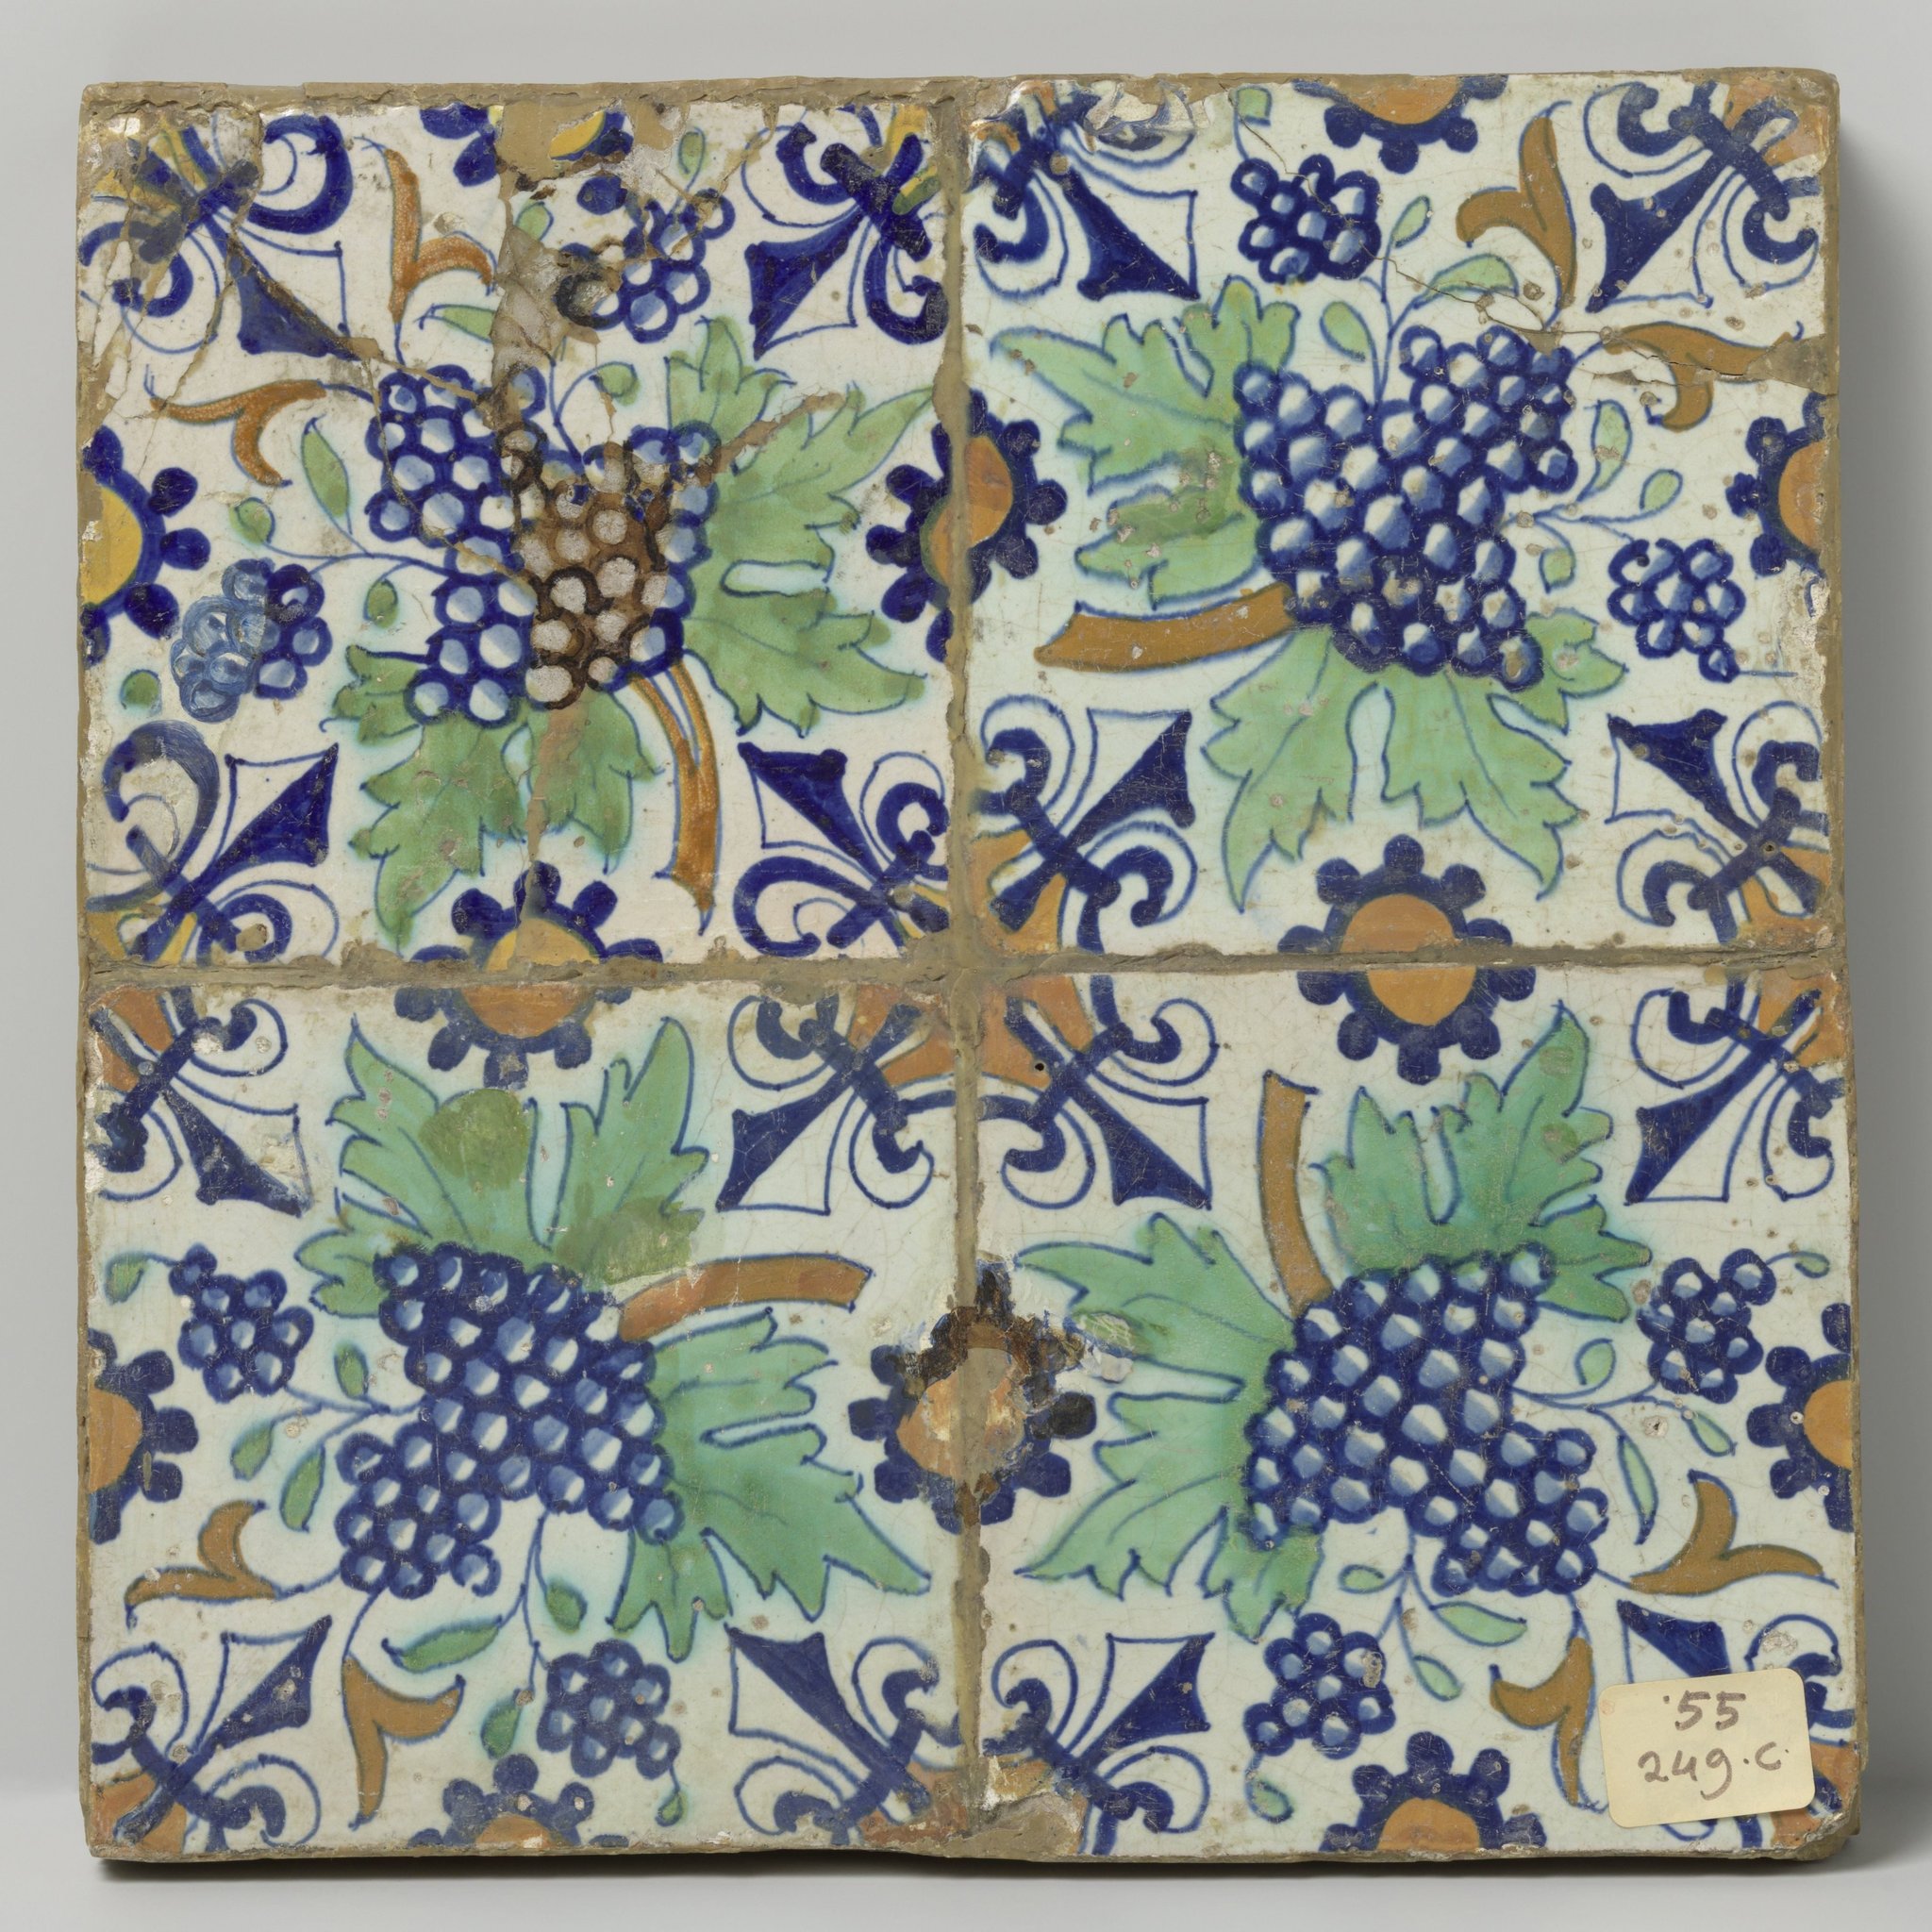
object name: tegelveld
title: Veld van vier tegels met druiventrossen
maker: Anonymous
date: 1600-1625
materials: earthenware, glaze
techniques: maiolica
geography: netherlands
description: Veld van vier tegels (2 x 2) elk met een veelkleurig (blauw, groen, oranje en geel) geschilderde druiventros, diagonaal geplaatst. Langs de randen, een halve rozet en in de hoeken, een lelie.